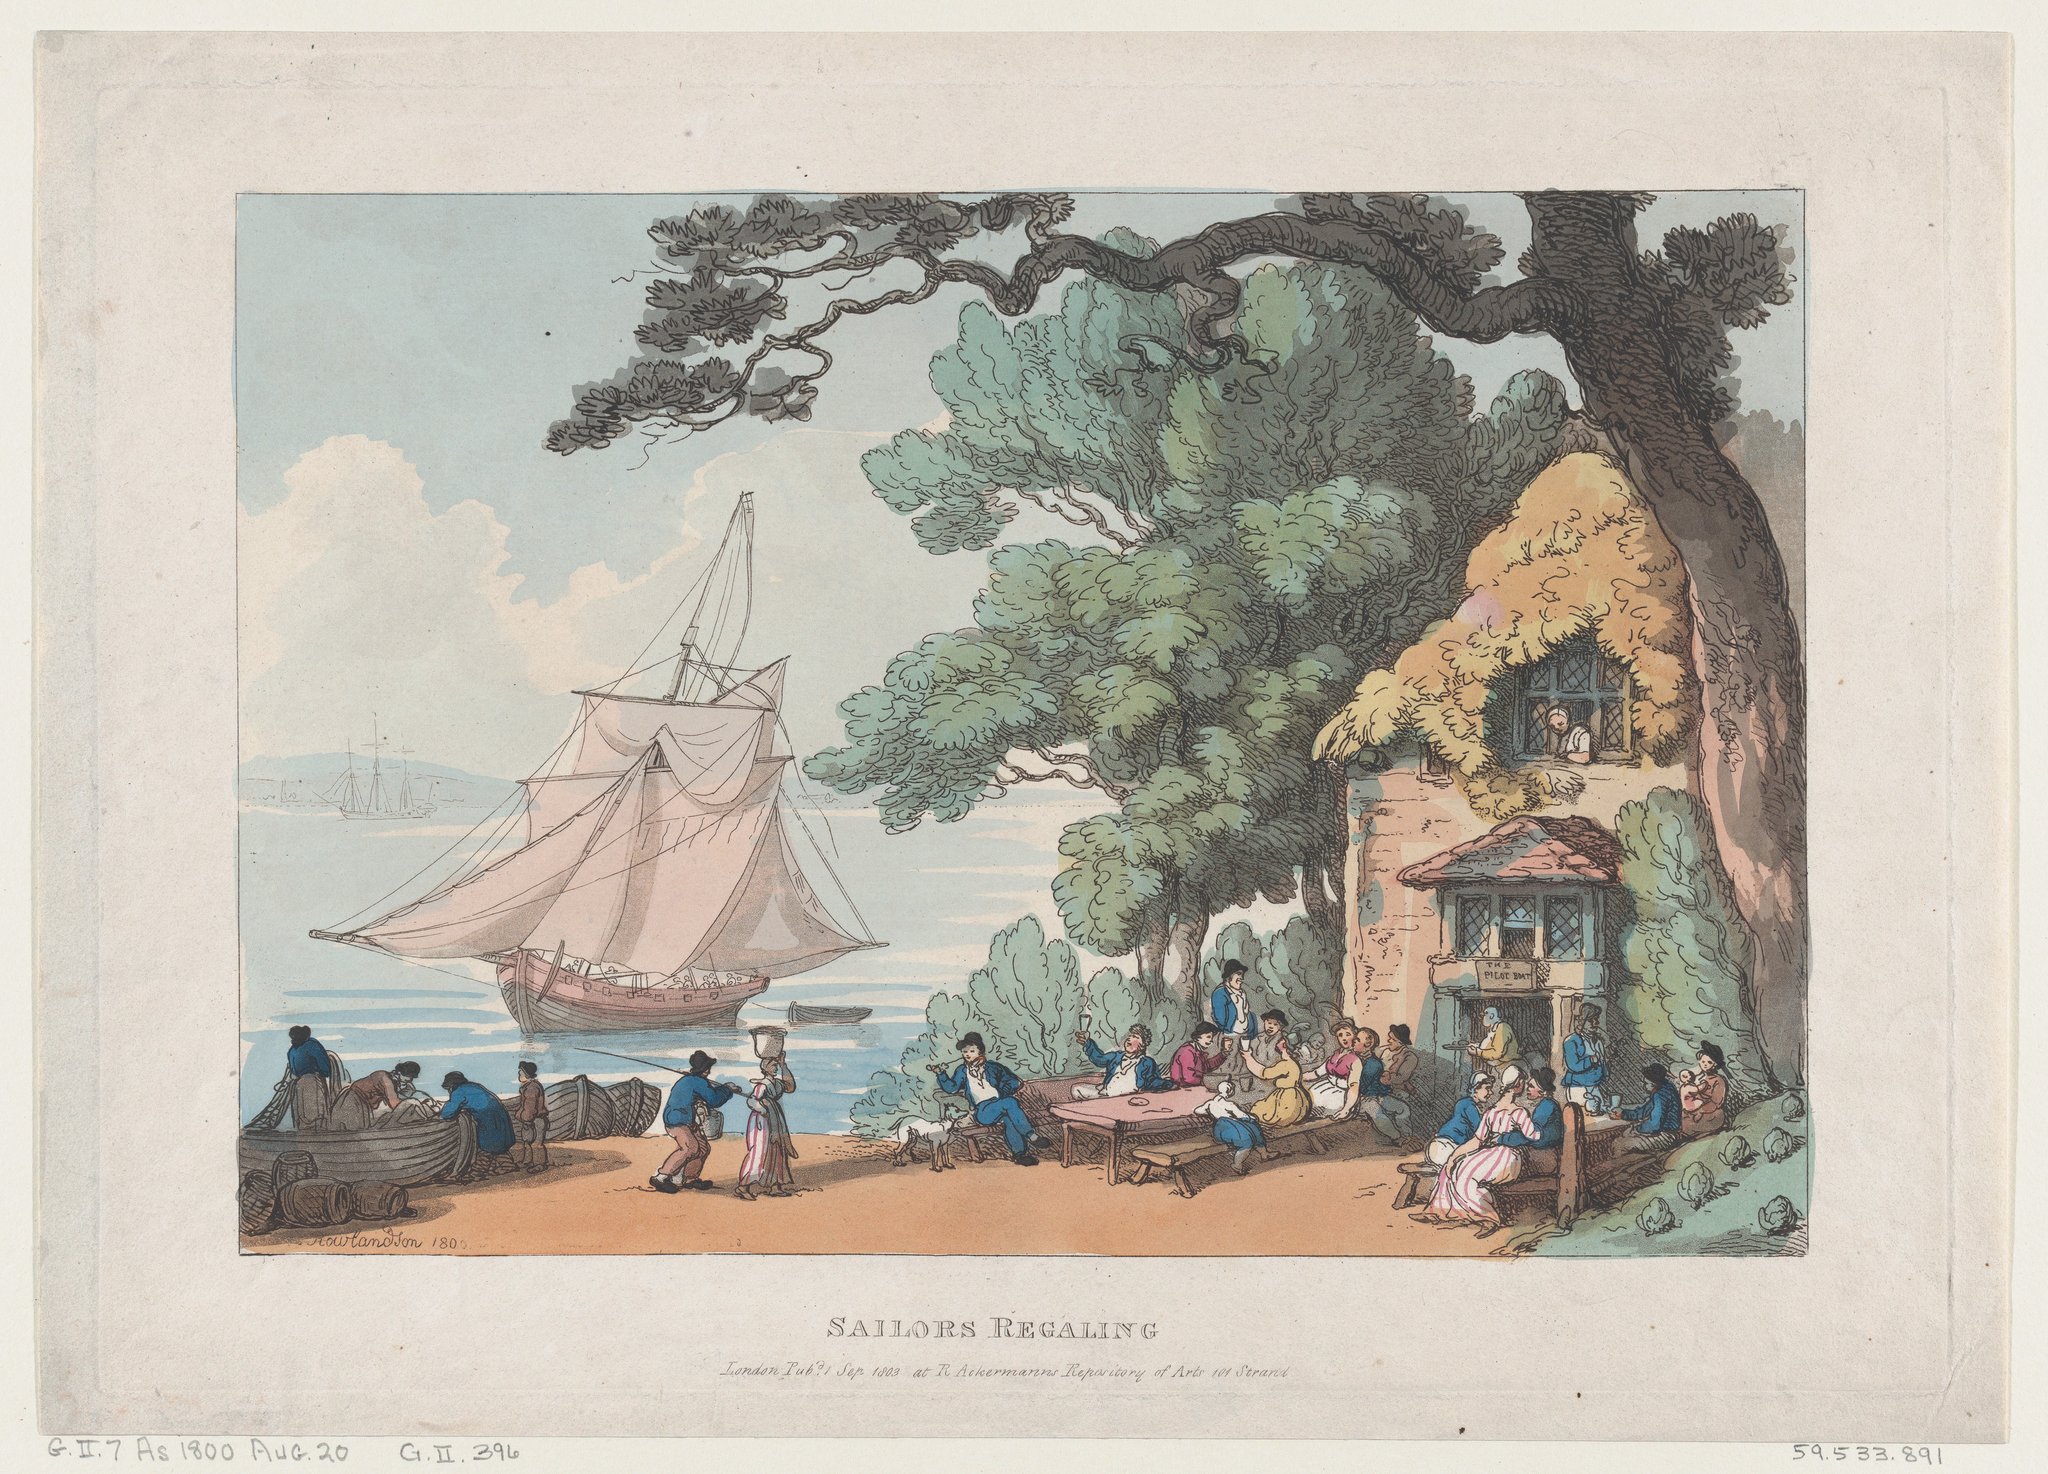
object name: print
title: Sailors Regaling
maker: thomas rowlandson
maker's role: artist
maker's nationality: british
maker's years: 1757-1827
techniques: etching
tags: men,women,drinking,sailors,ships